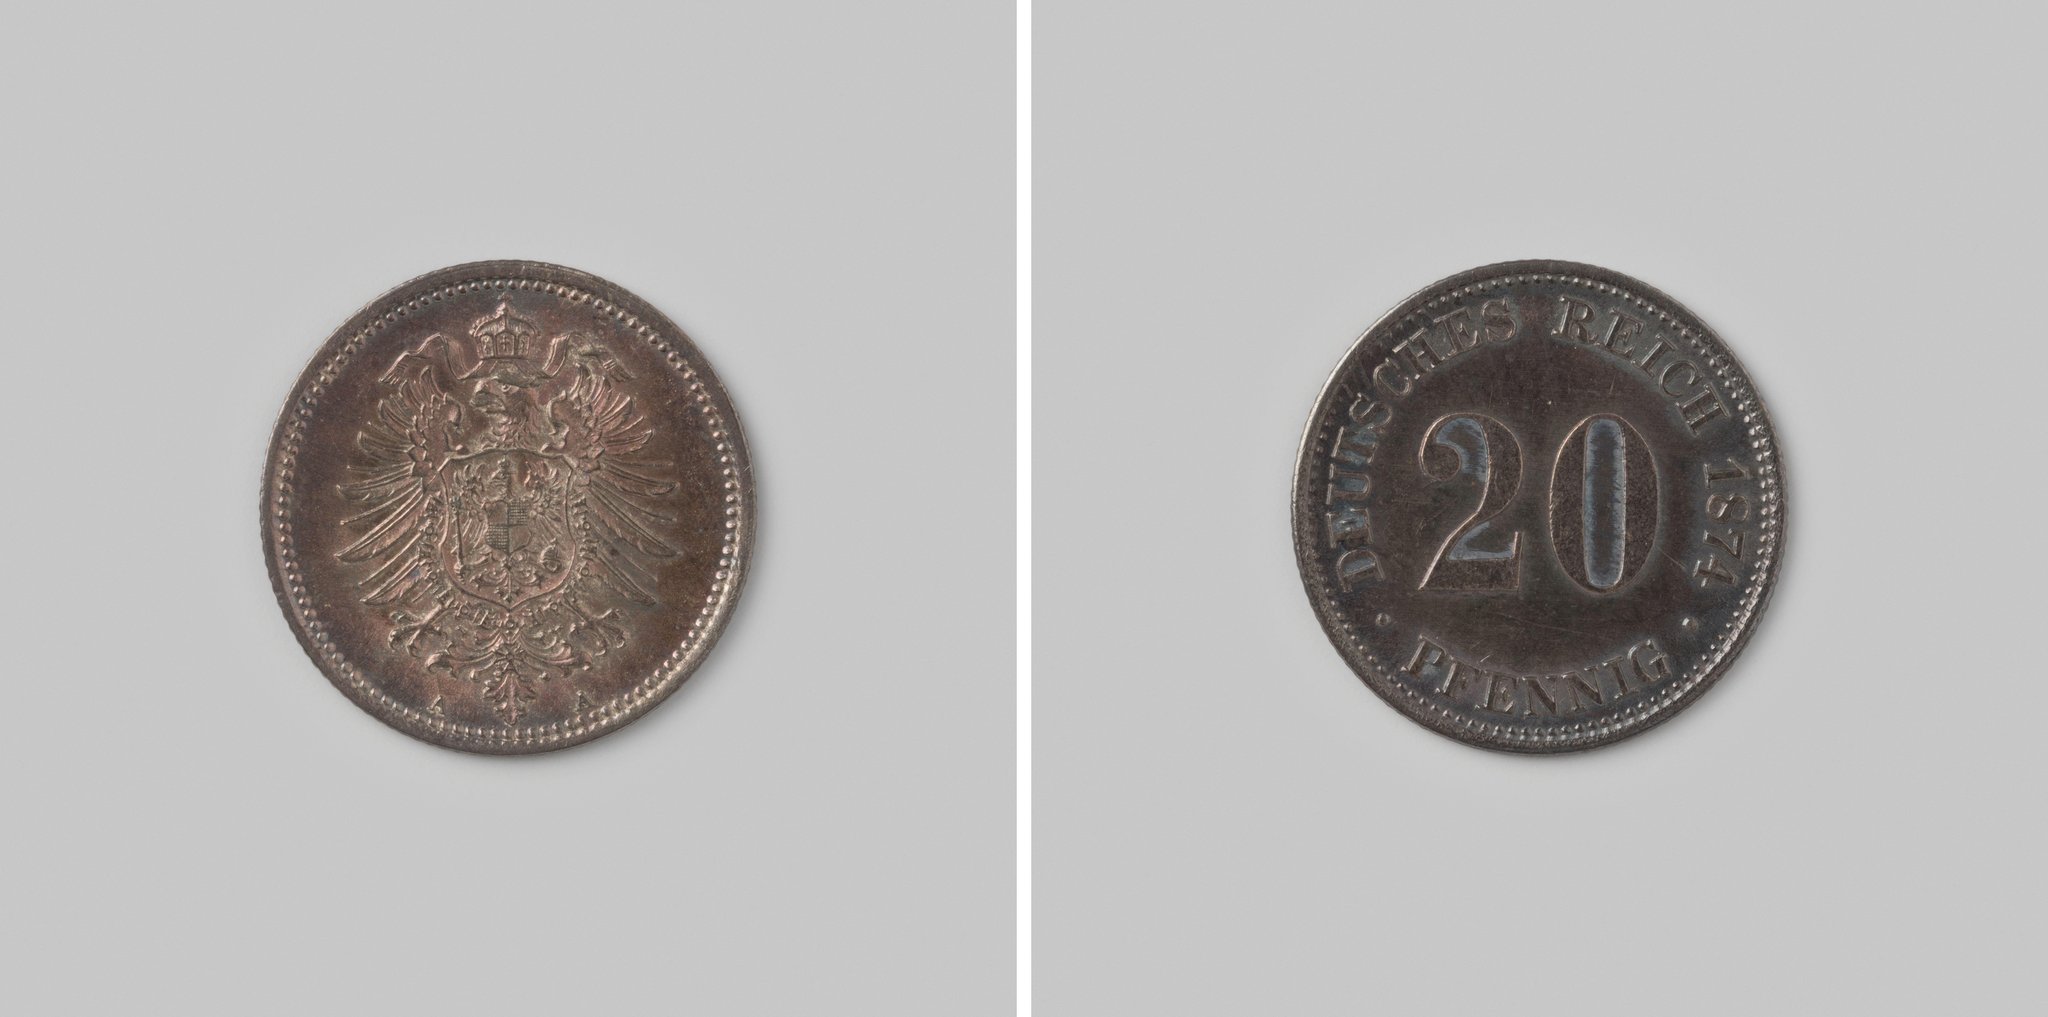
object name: twintig pfennig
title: Duitse Rijk, 20 Pfennig,1874 A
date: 1874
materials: silver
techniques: striking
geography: berlin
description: Zilveren munt. Voorzijde: gekroonde enkelkoppige adelaar naar links met op borst door keten van orde met juweel omhangen samengesteld wapenschild. Daaronder twee letters A. Keerzijde: waarde-aanduiding in twee regels. Jaartal in omschrift. Kartelrand.